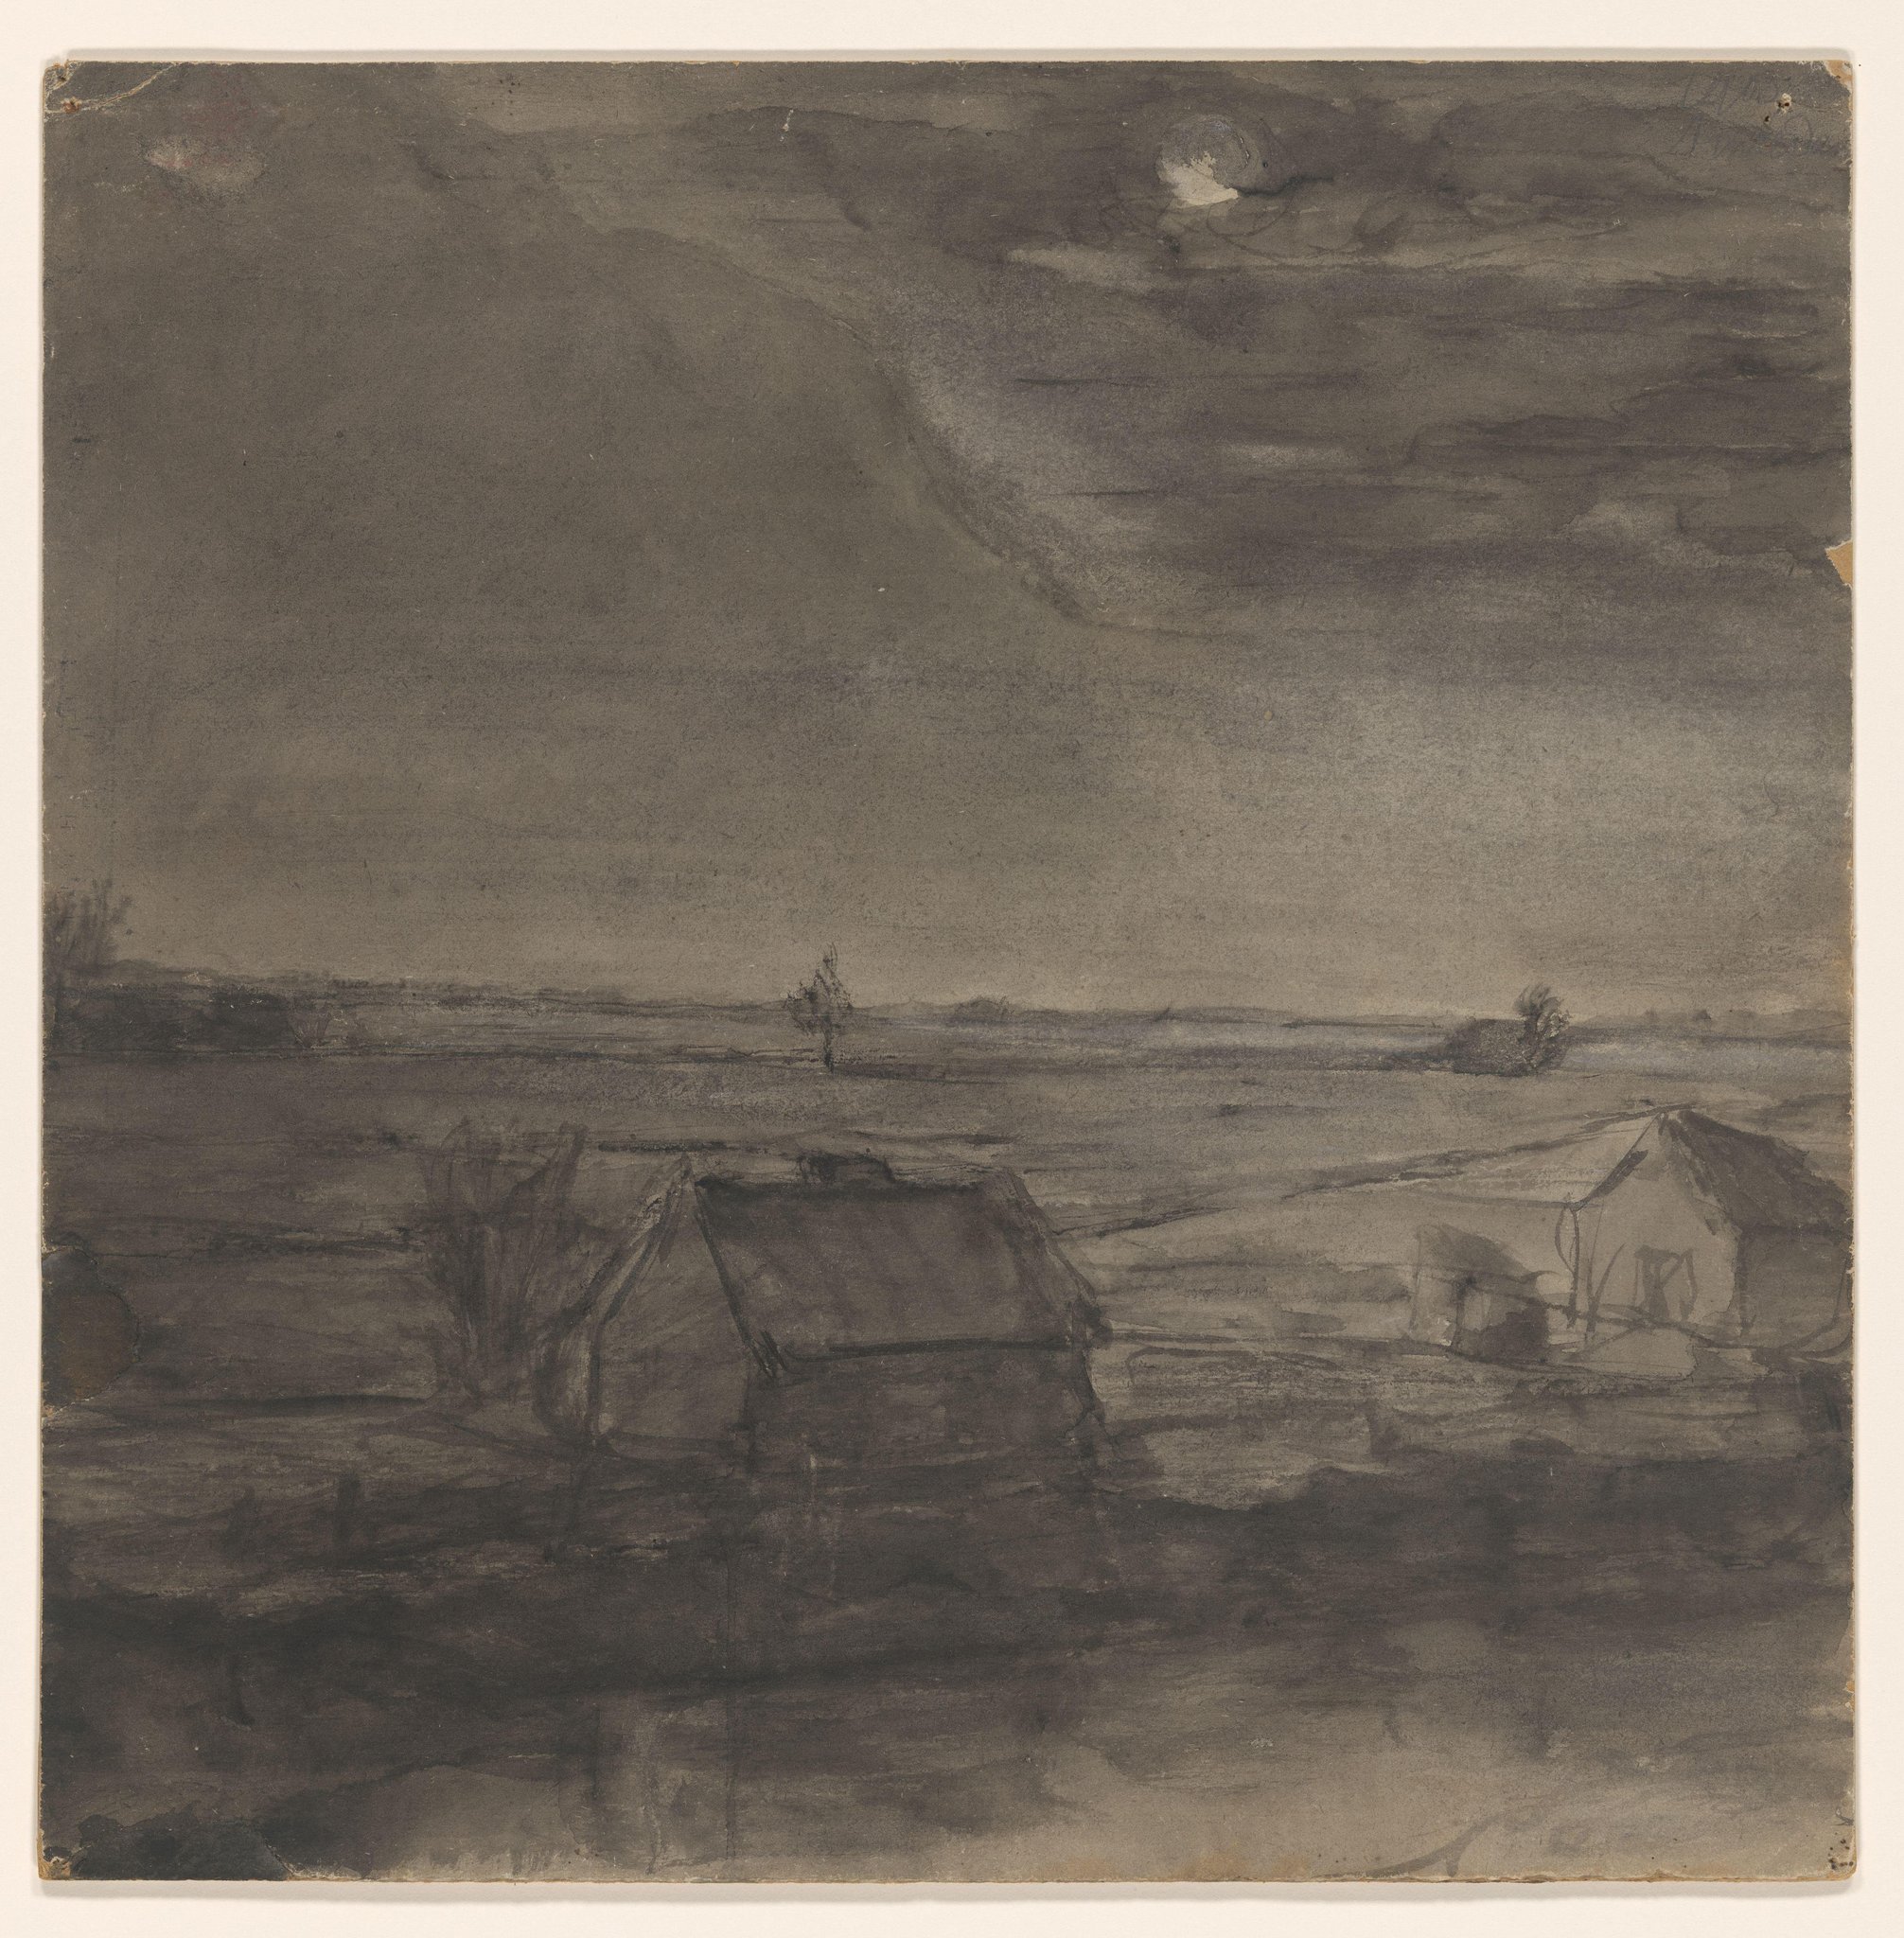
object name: drawing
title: Landschap bij maanlicht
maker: wilhelmus johannes steenhoff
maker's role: draughtsman, print maker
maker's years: 1863-1932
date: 1873-1932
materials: cardboard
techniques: brush